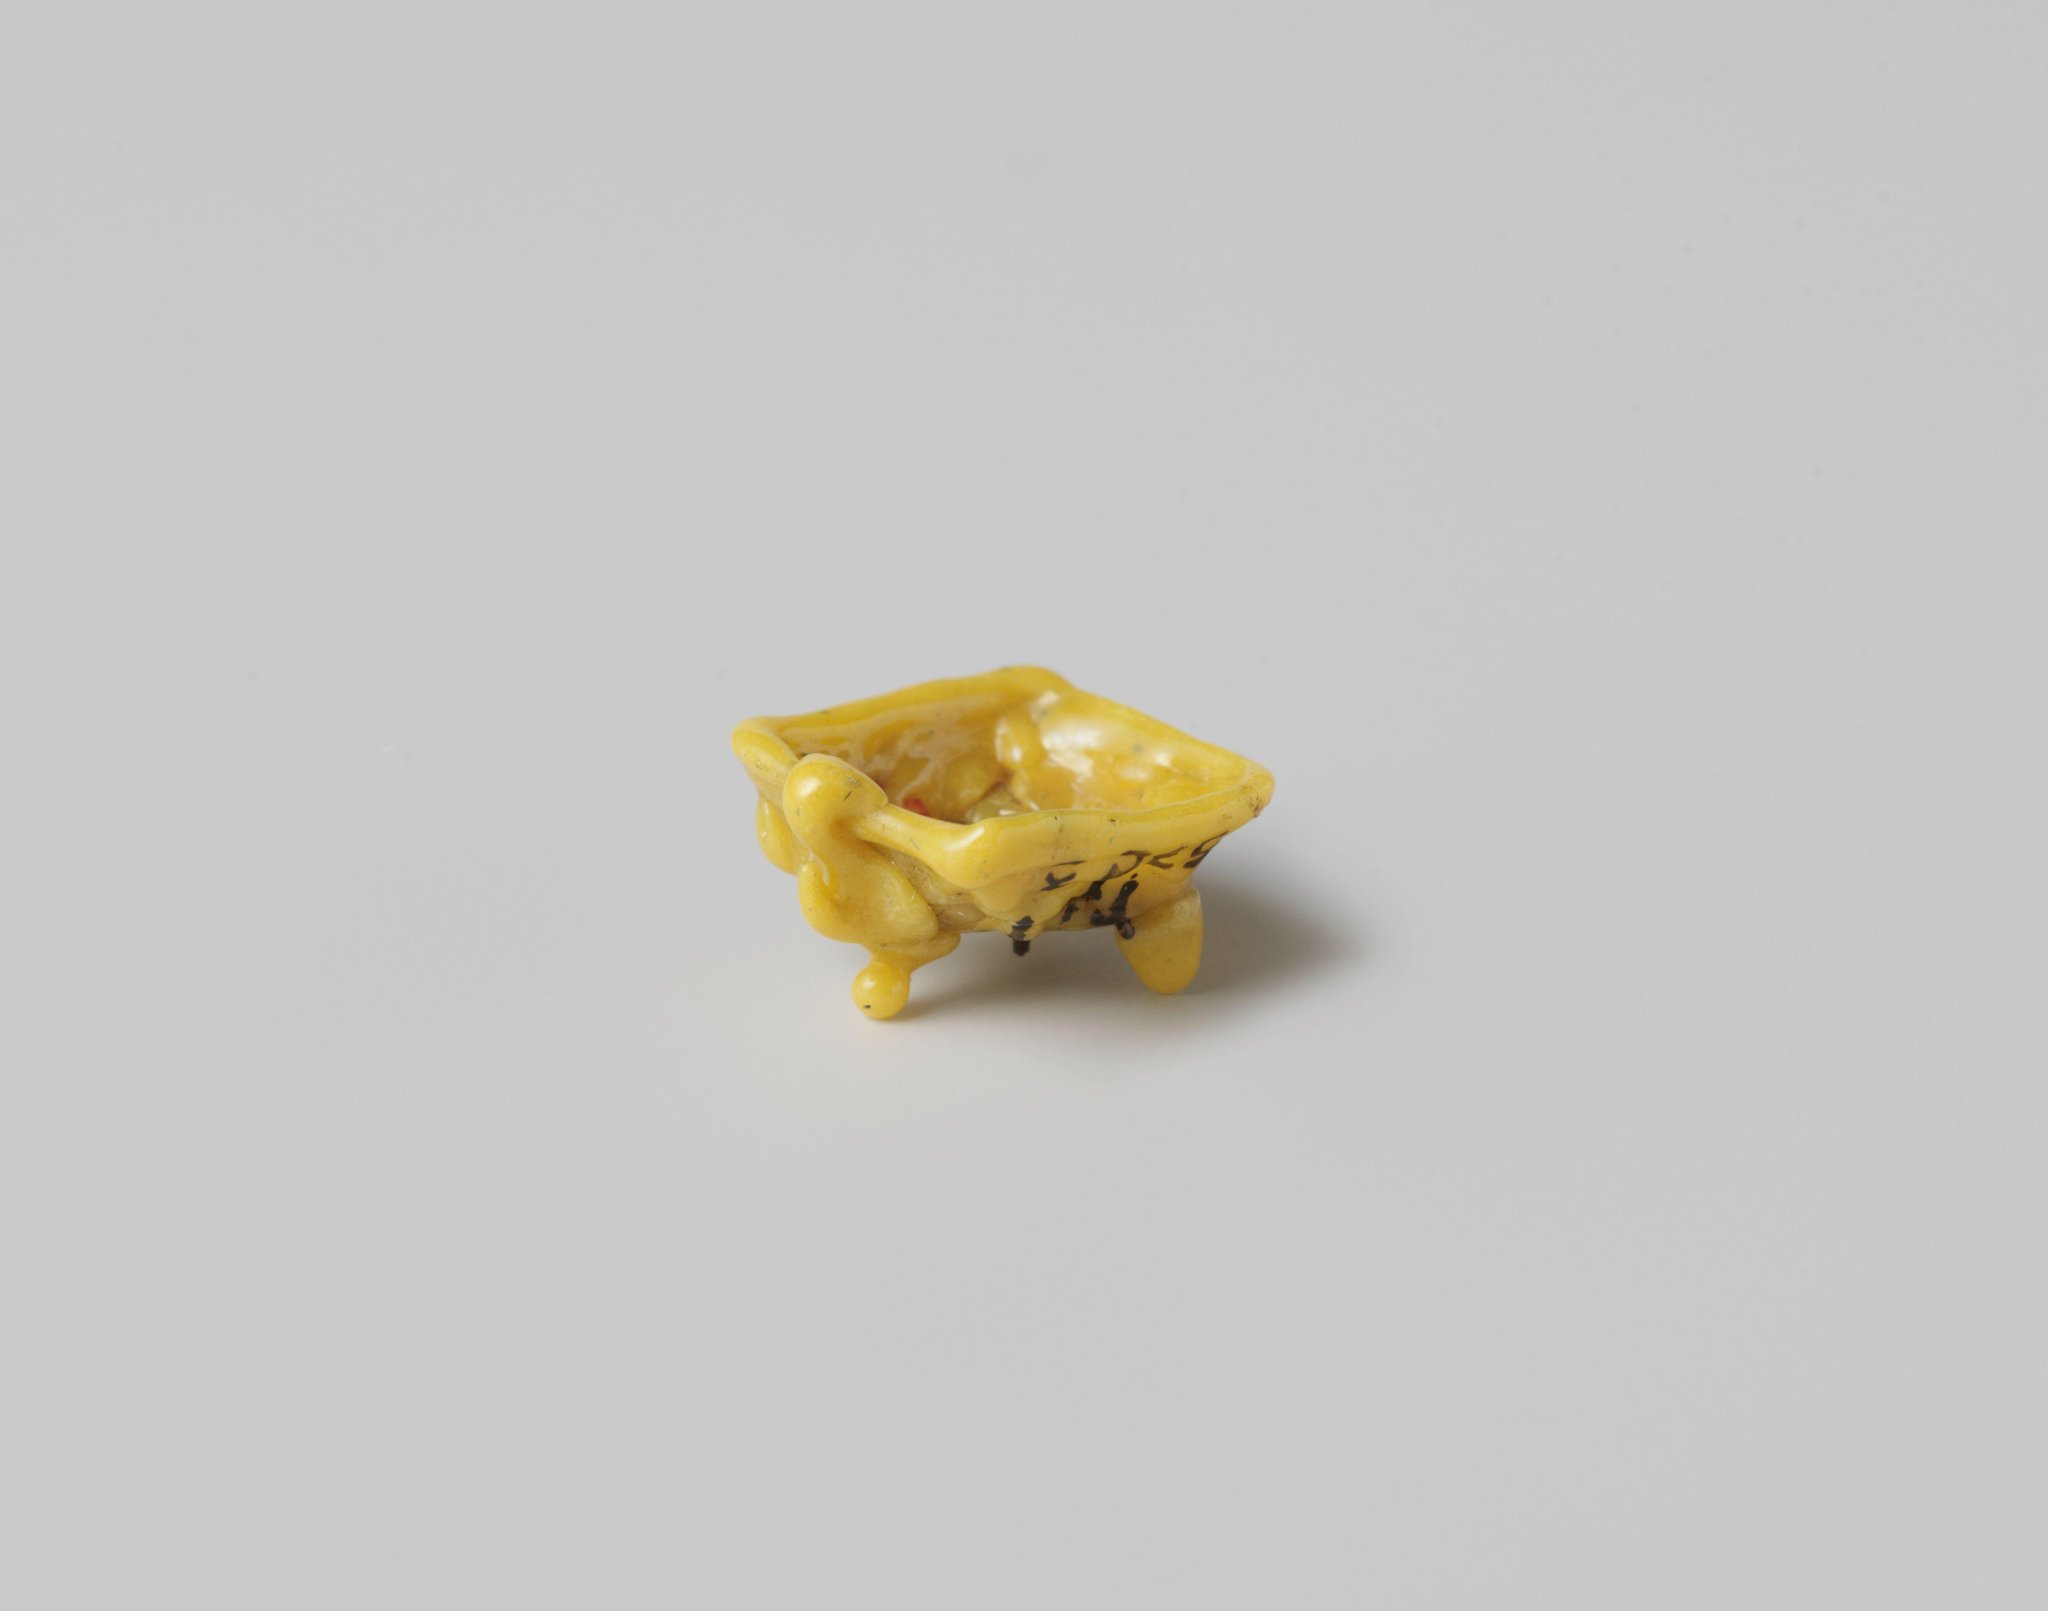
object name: miniature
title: Vuurtest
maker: Anonymous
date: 1675-1699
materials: glass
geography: amsterdam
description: Drie vuurtesten van geel glas op drie poten met oor, vervaardigd van massieve glasmassa; binnenin resten van rode verf.